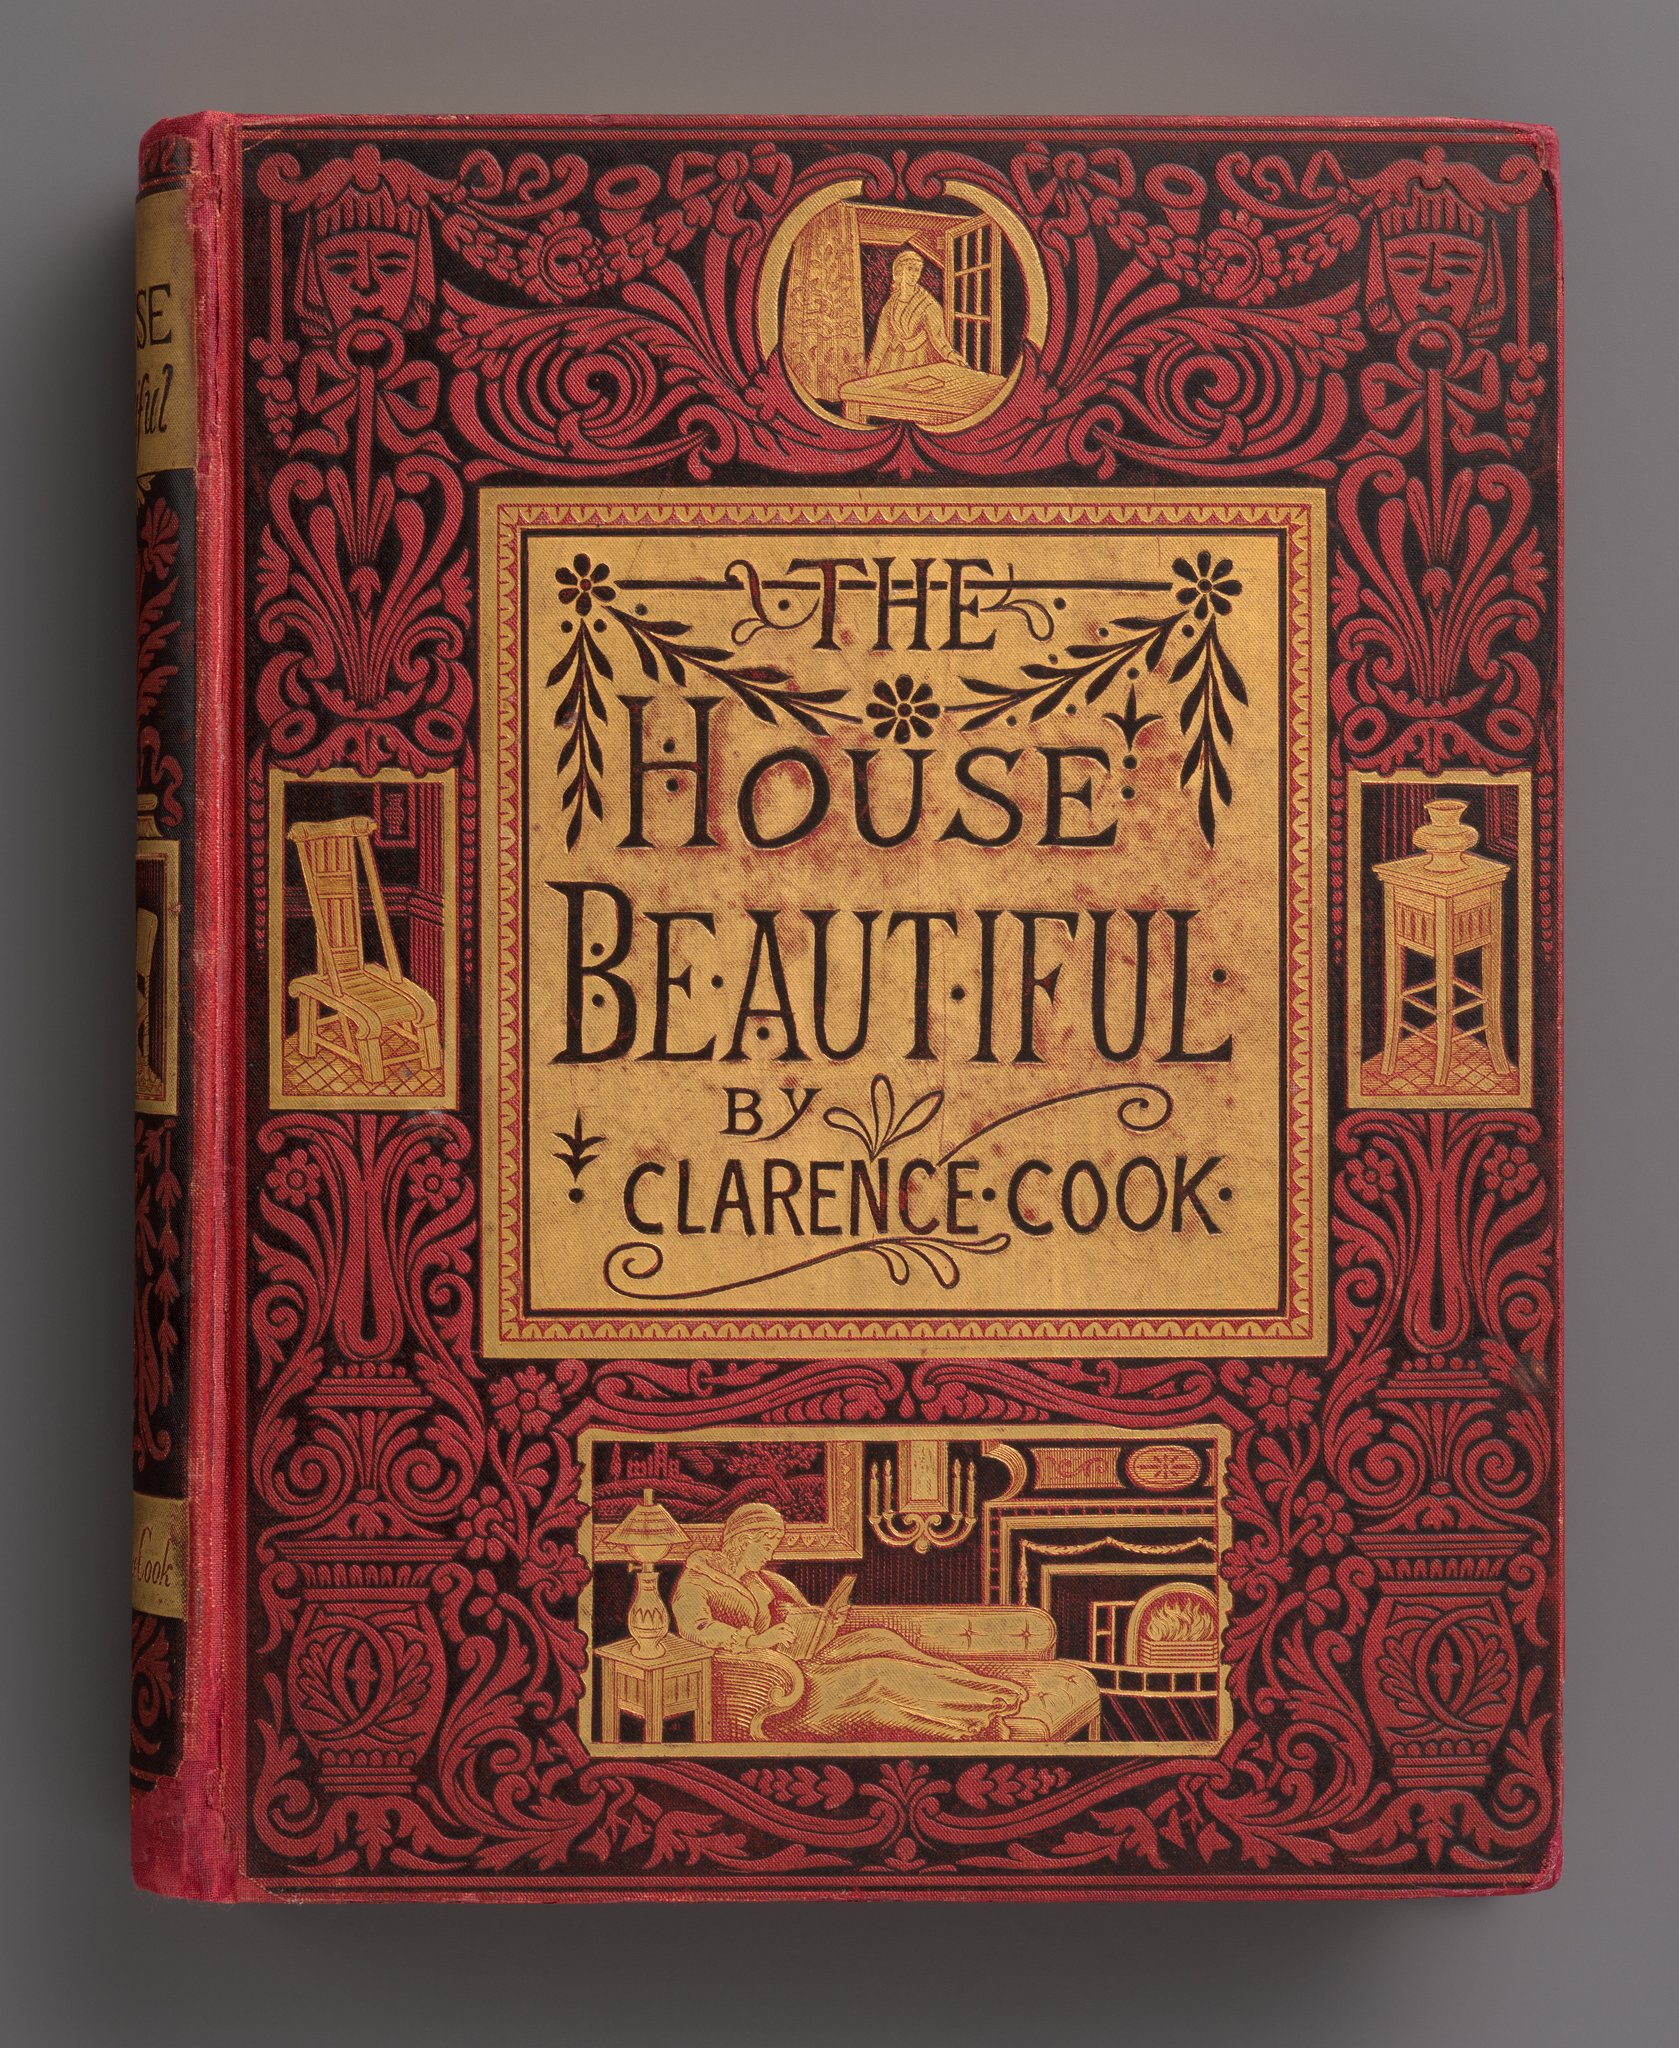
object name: book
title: The House Beautiful, Essays on Beds and Tables, Stools and Candlesticks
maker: clarence cook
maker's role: author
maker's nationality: american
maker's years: 1828-1900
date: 1878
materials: wood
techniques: engraving, lithograph